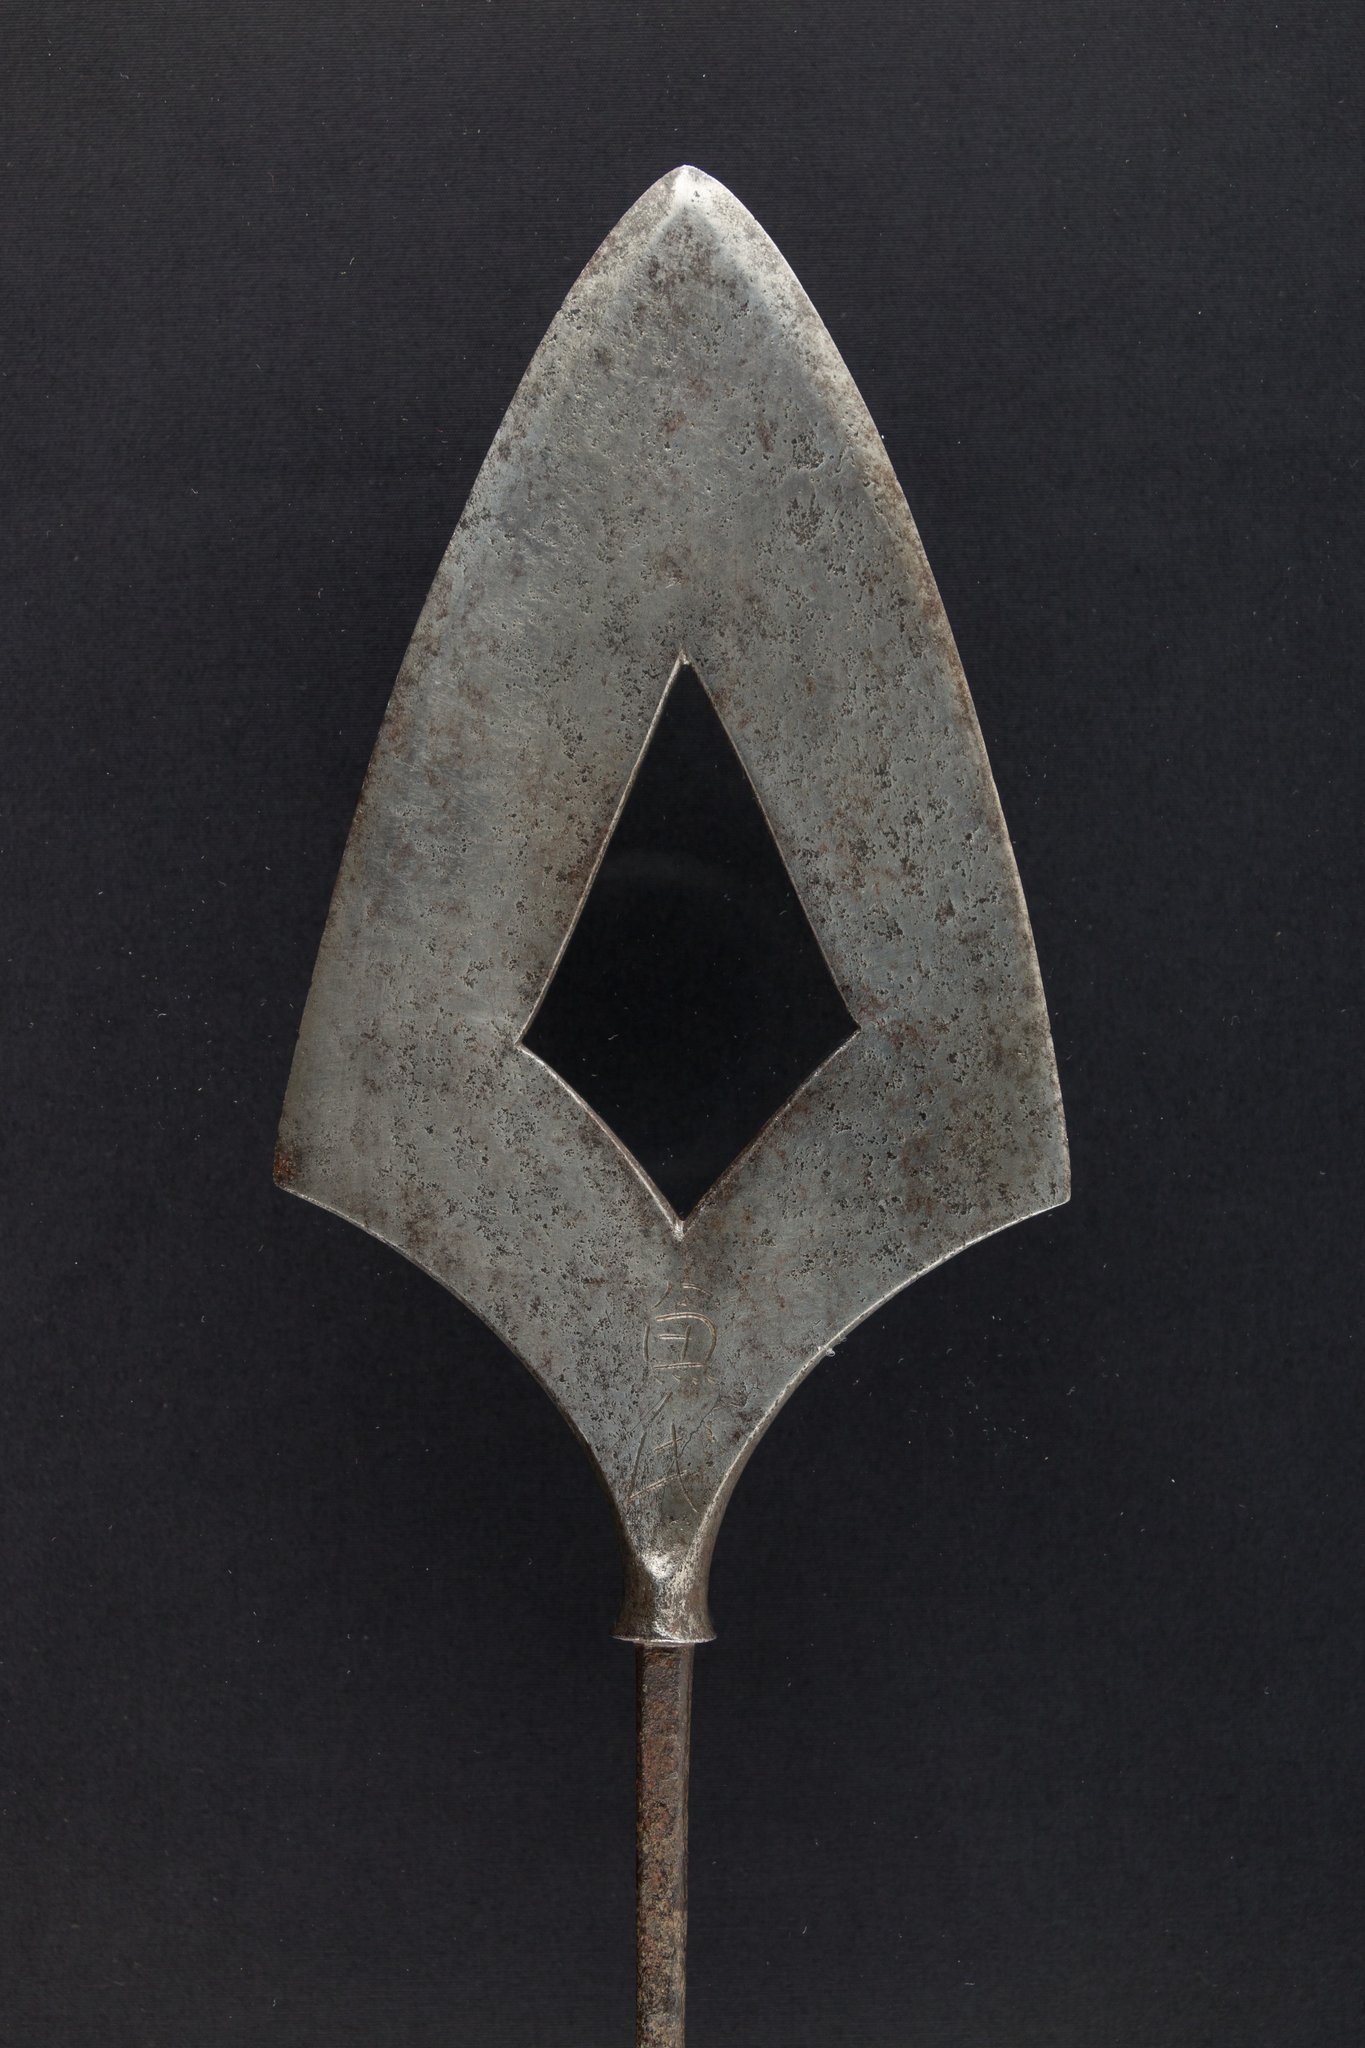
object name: arrowhead i yanone i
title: Arrowhead (Yanone)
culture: japanese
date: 1701-1800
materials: steel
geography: japan